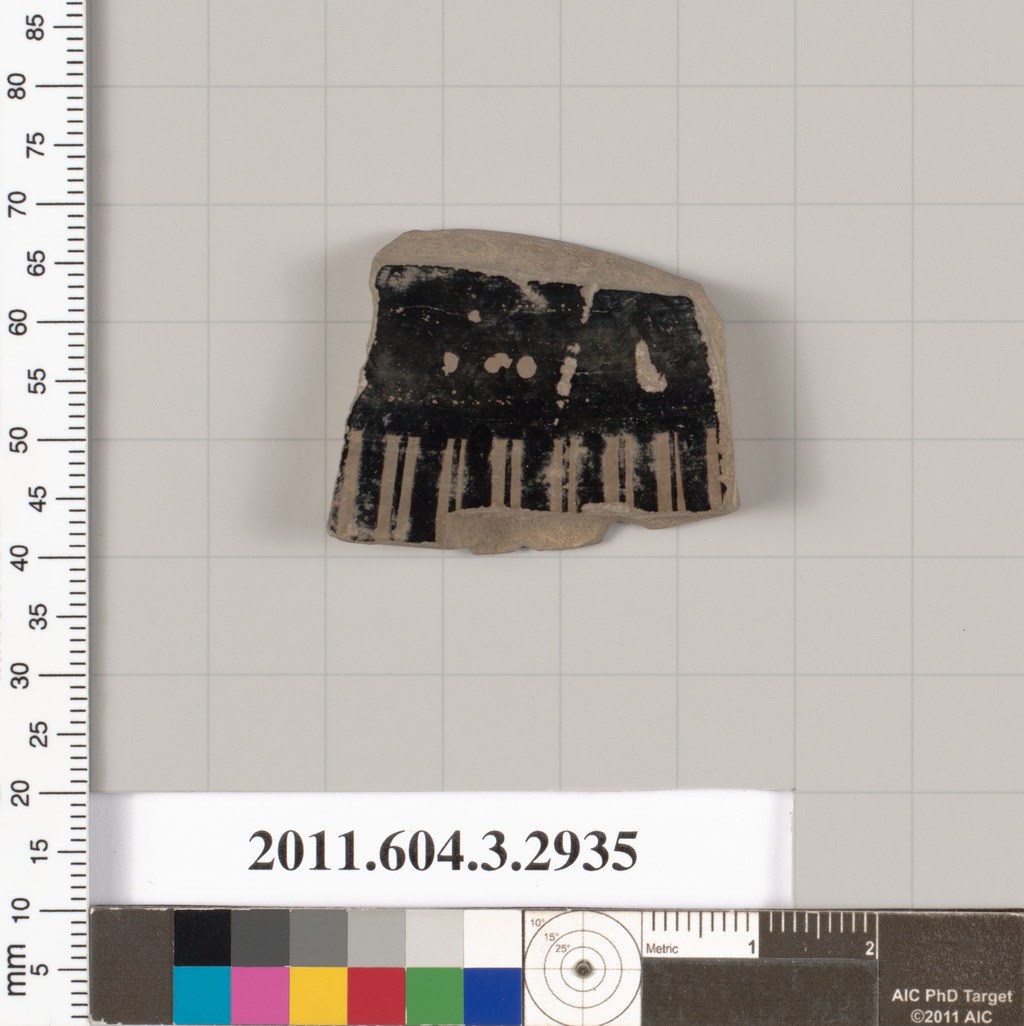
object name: lid fragment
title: Terracotta fragment of a lid?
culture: greek, attic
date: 534-468 BCE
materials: terracotta